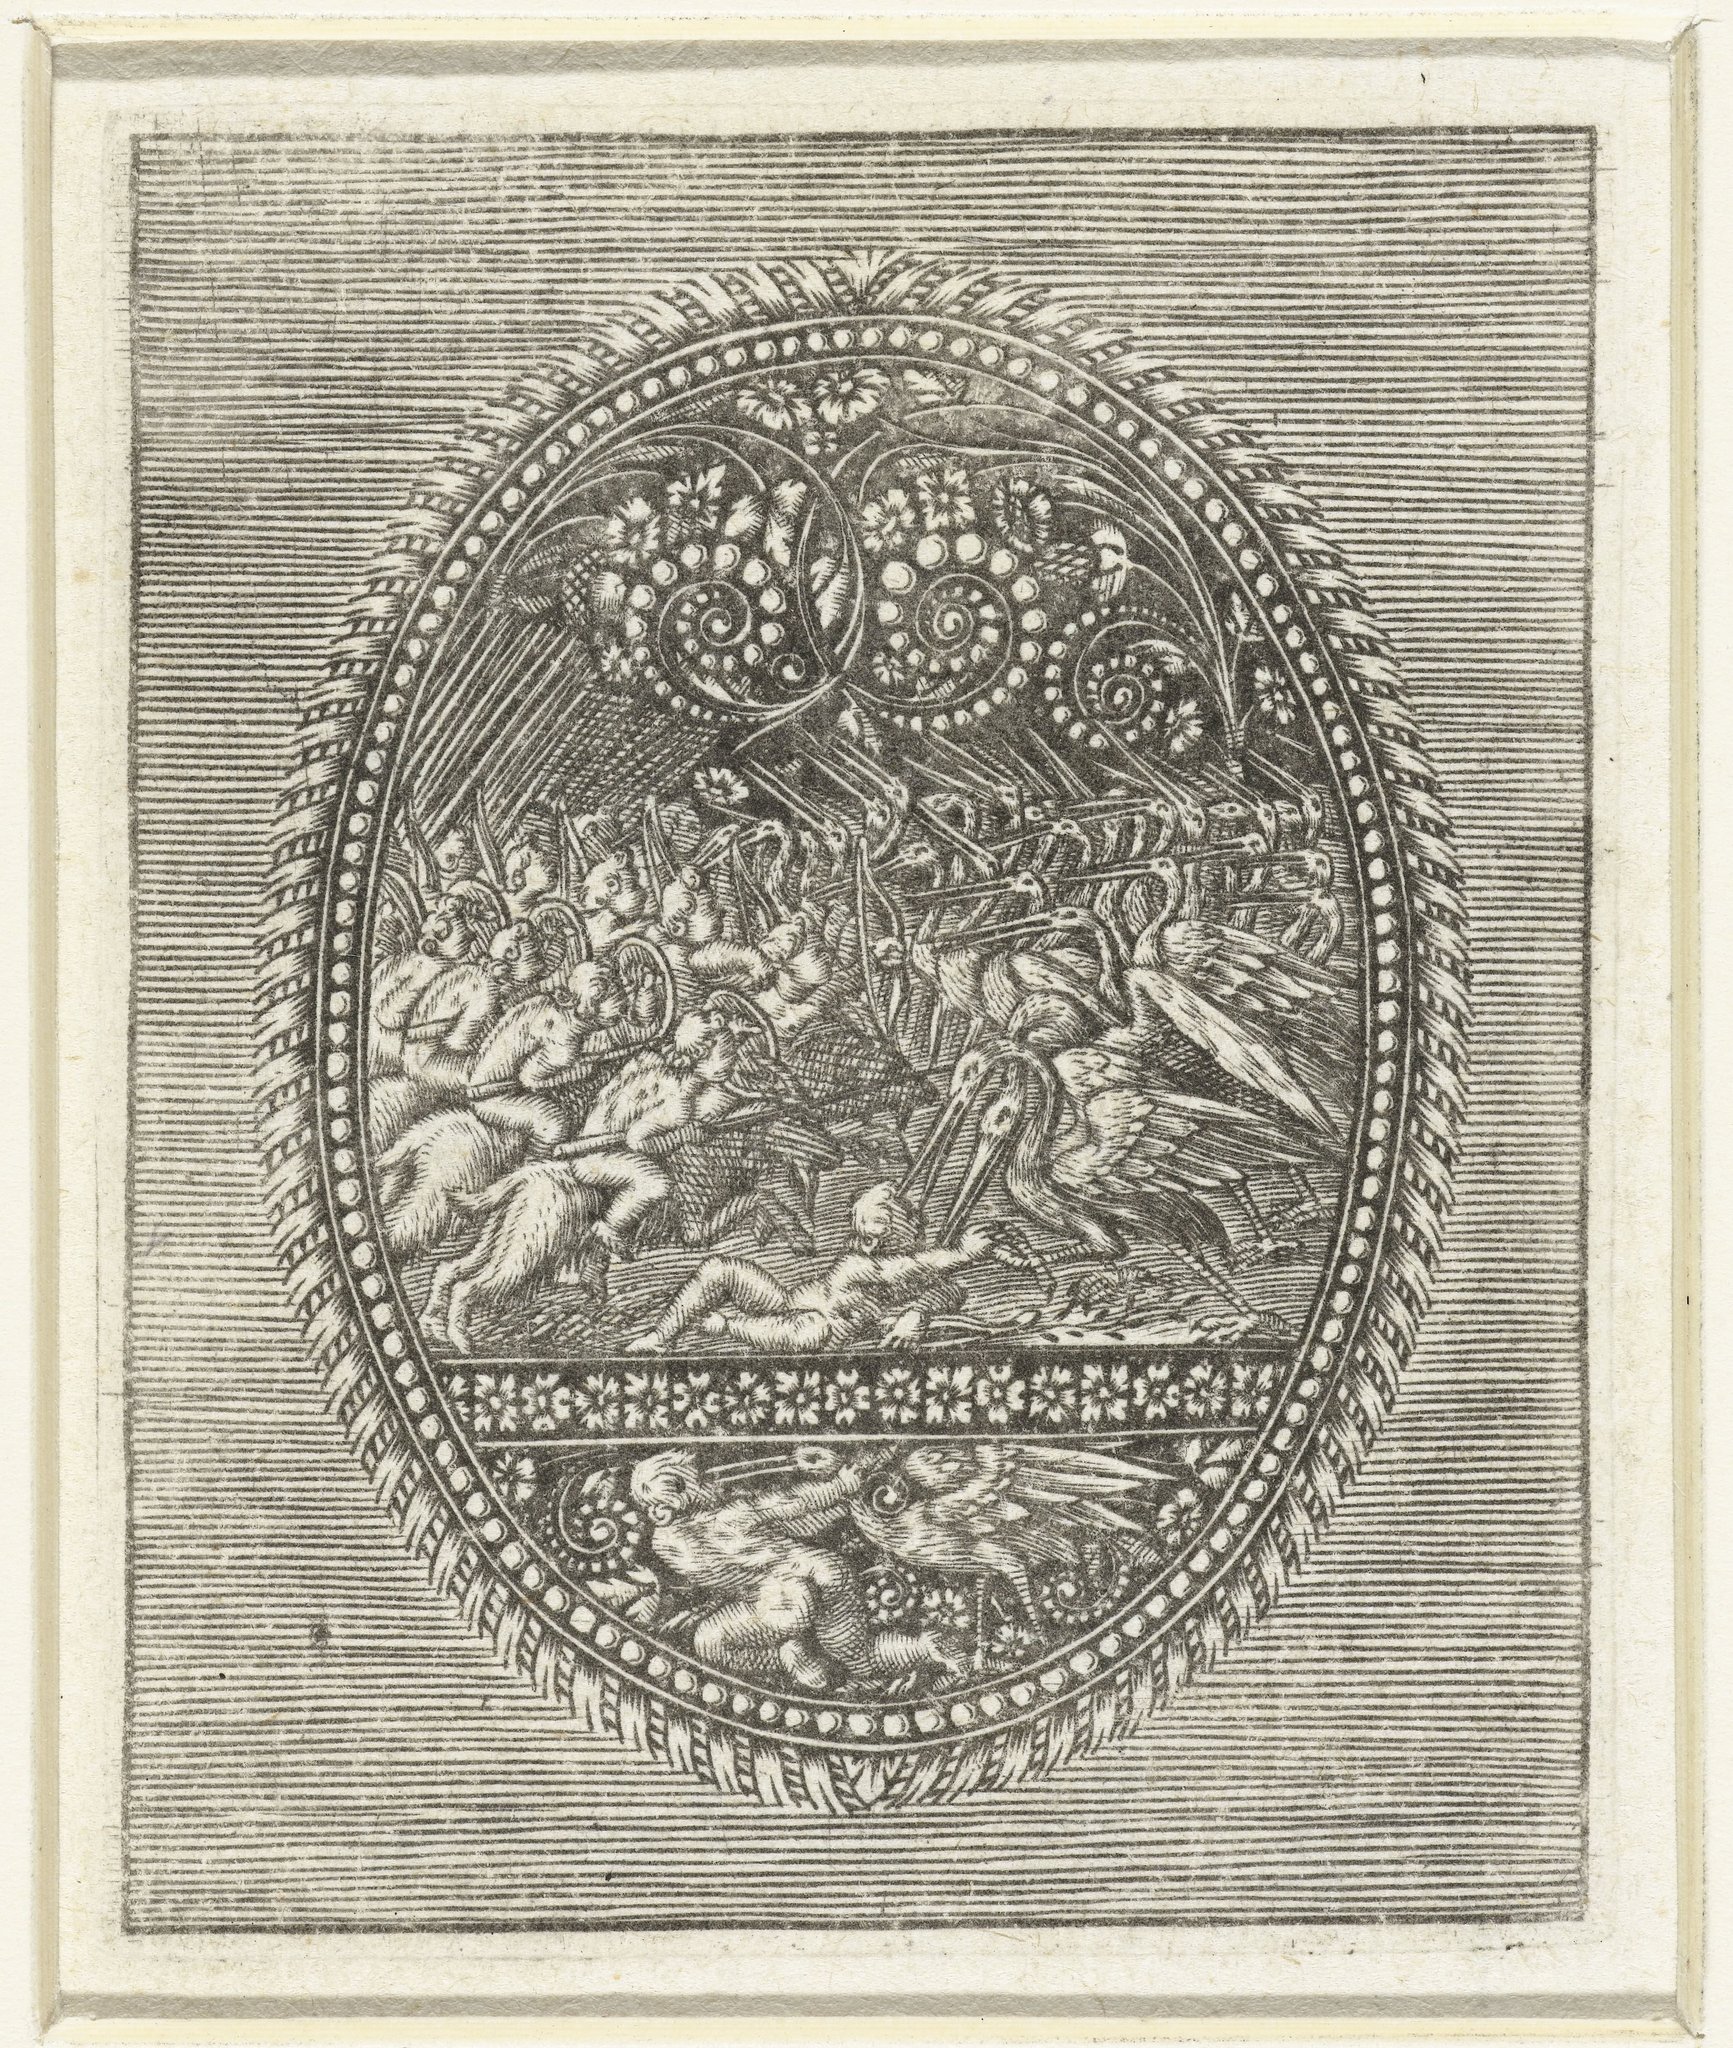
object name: ornament print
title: Ovale medaillons met spelende kinderen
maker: antoine jacquard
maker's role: print maker, publisher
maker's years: -1640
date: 1610-1615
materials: paper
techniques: engraving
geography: france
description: Ongenummerd blad uit serie van 10 bladen met ontwerpen voor juwelen.